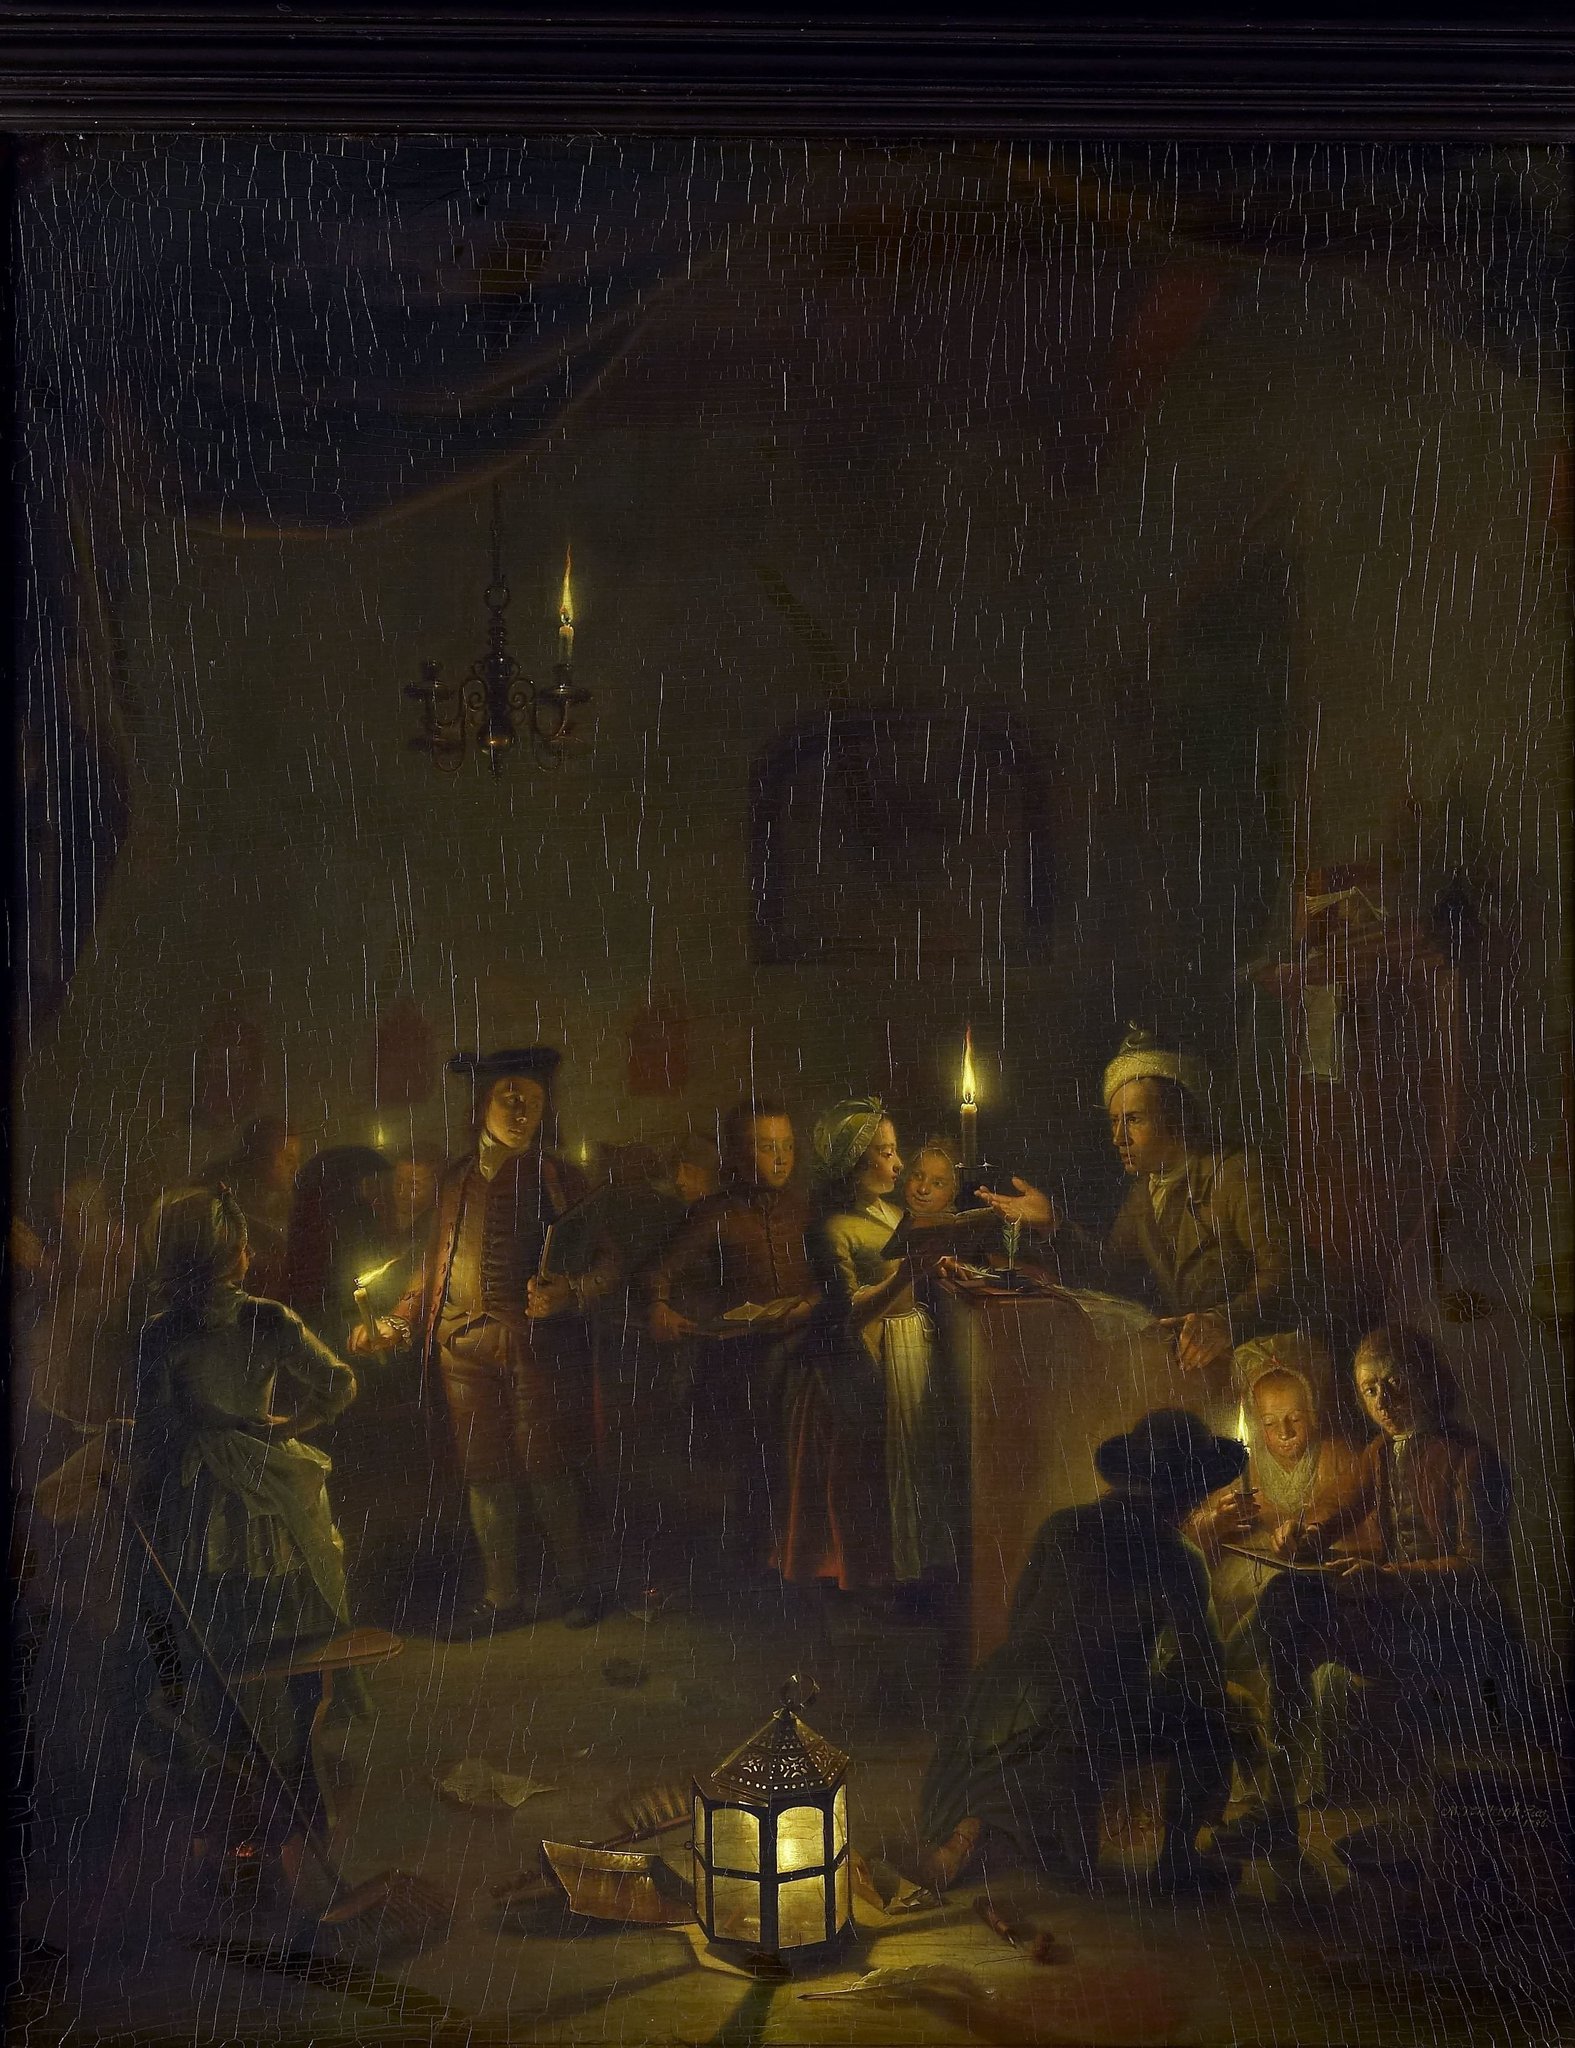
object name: painting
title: The Night School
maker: michiel versteegh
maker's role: painter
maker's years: 1756-1843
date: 1786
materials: oil, panel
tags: candle, lantern, elementary school; class, form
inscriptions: signature and date: ‘M. Versteegh Fecit 1786’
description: De avondschool. Interieur met een klas van de avondschool bij kaarslicht. Leerlingen staan in de rij om hun werk door de schoolmeester te laten nakijken. Op de voorgrond rechts is een jongen aan het schrijven of tekenen, op de vloer staat een lantaarn.